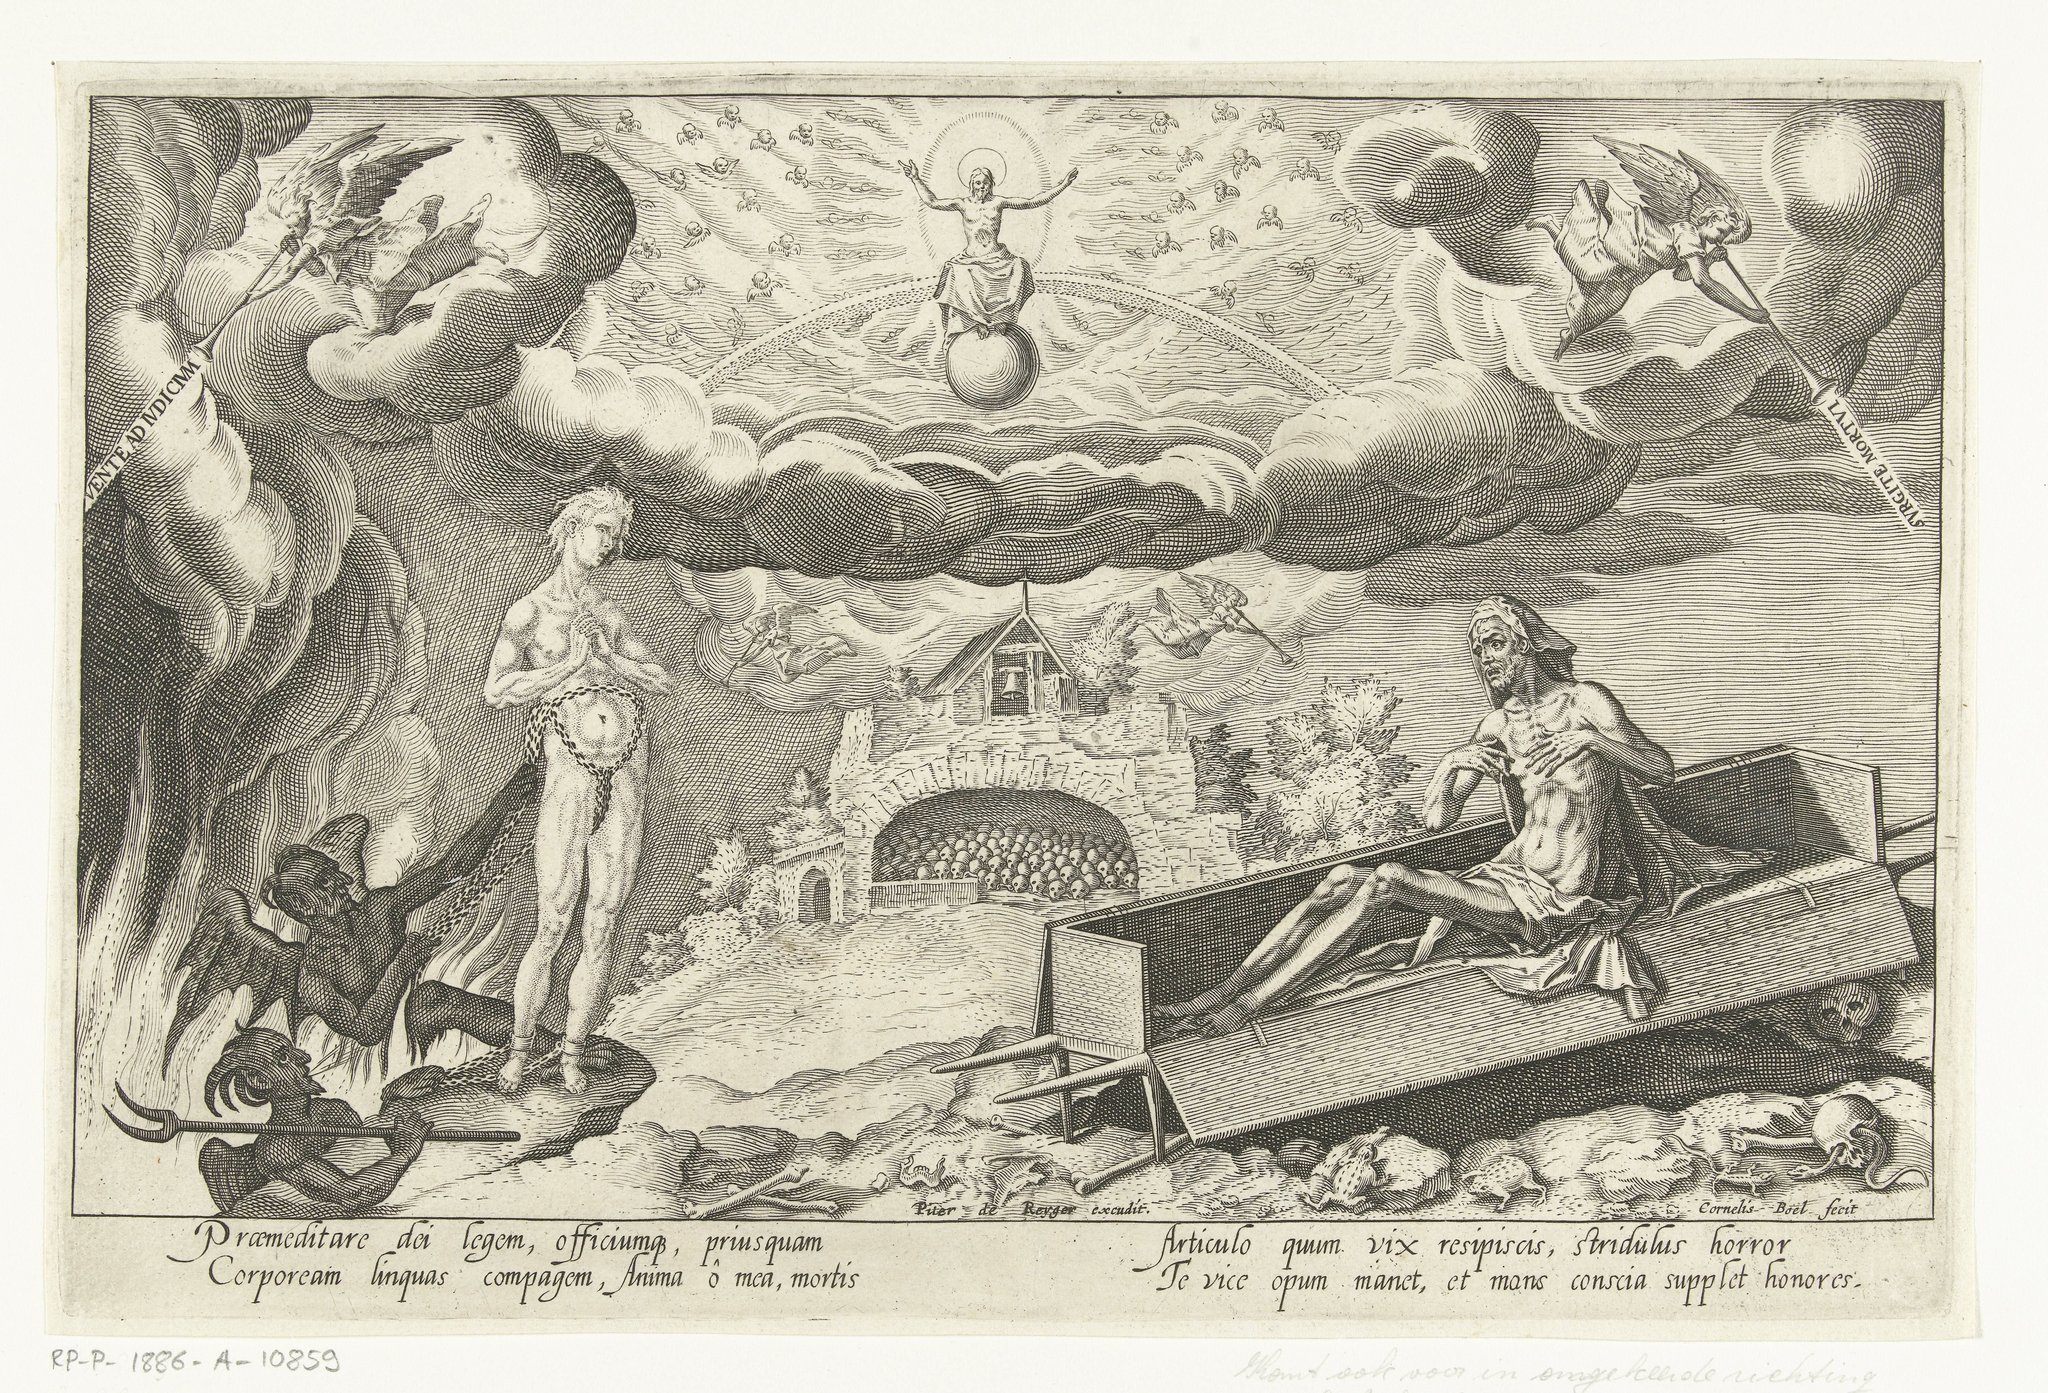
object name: print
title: Laatste oordeel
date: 1590-1650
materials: paper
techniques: engraving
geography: southern netherlands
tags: last judgement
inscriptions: collector's mark: Lugt 2228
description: Christus zit als rechter op de regenboog, zijn voeten rusten op de wereldbol. Hij maakt een spreekgebaar en wordt omringd door cherubijnen. Aan weerszijden van hem twee trompetterende engelen. Onder staat een dode op uit zijn graf, een ander wordt door twee duivels de hel ingetrokken. Met een Latijns onderschrift.